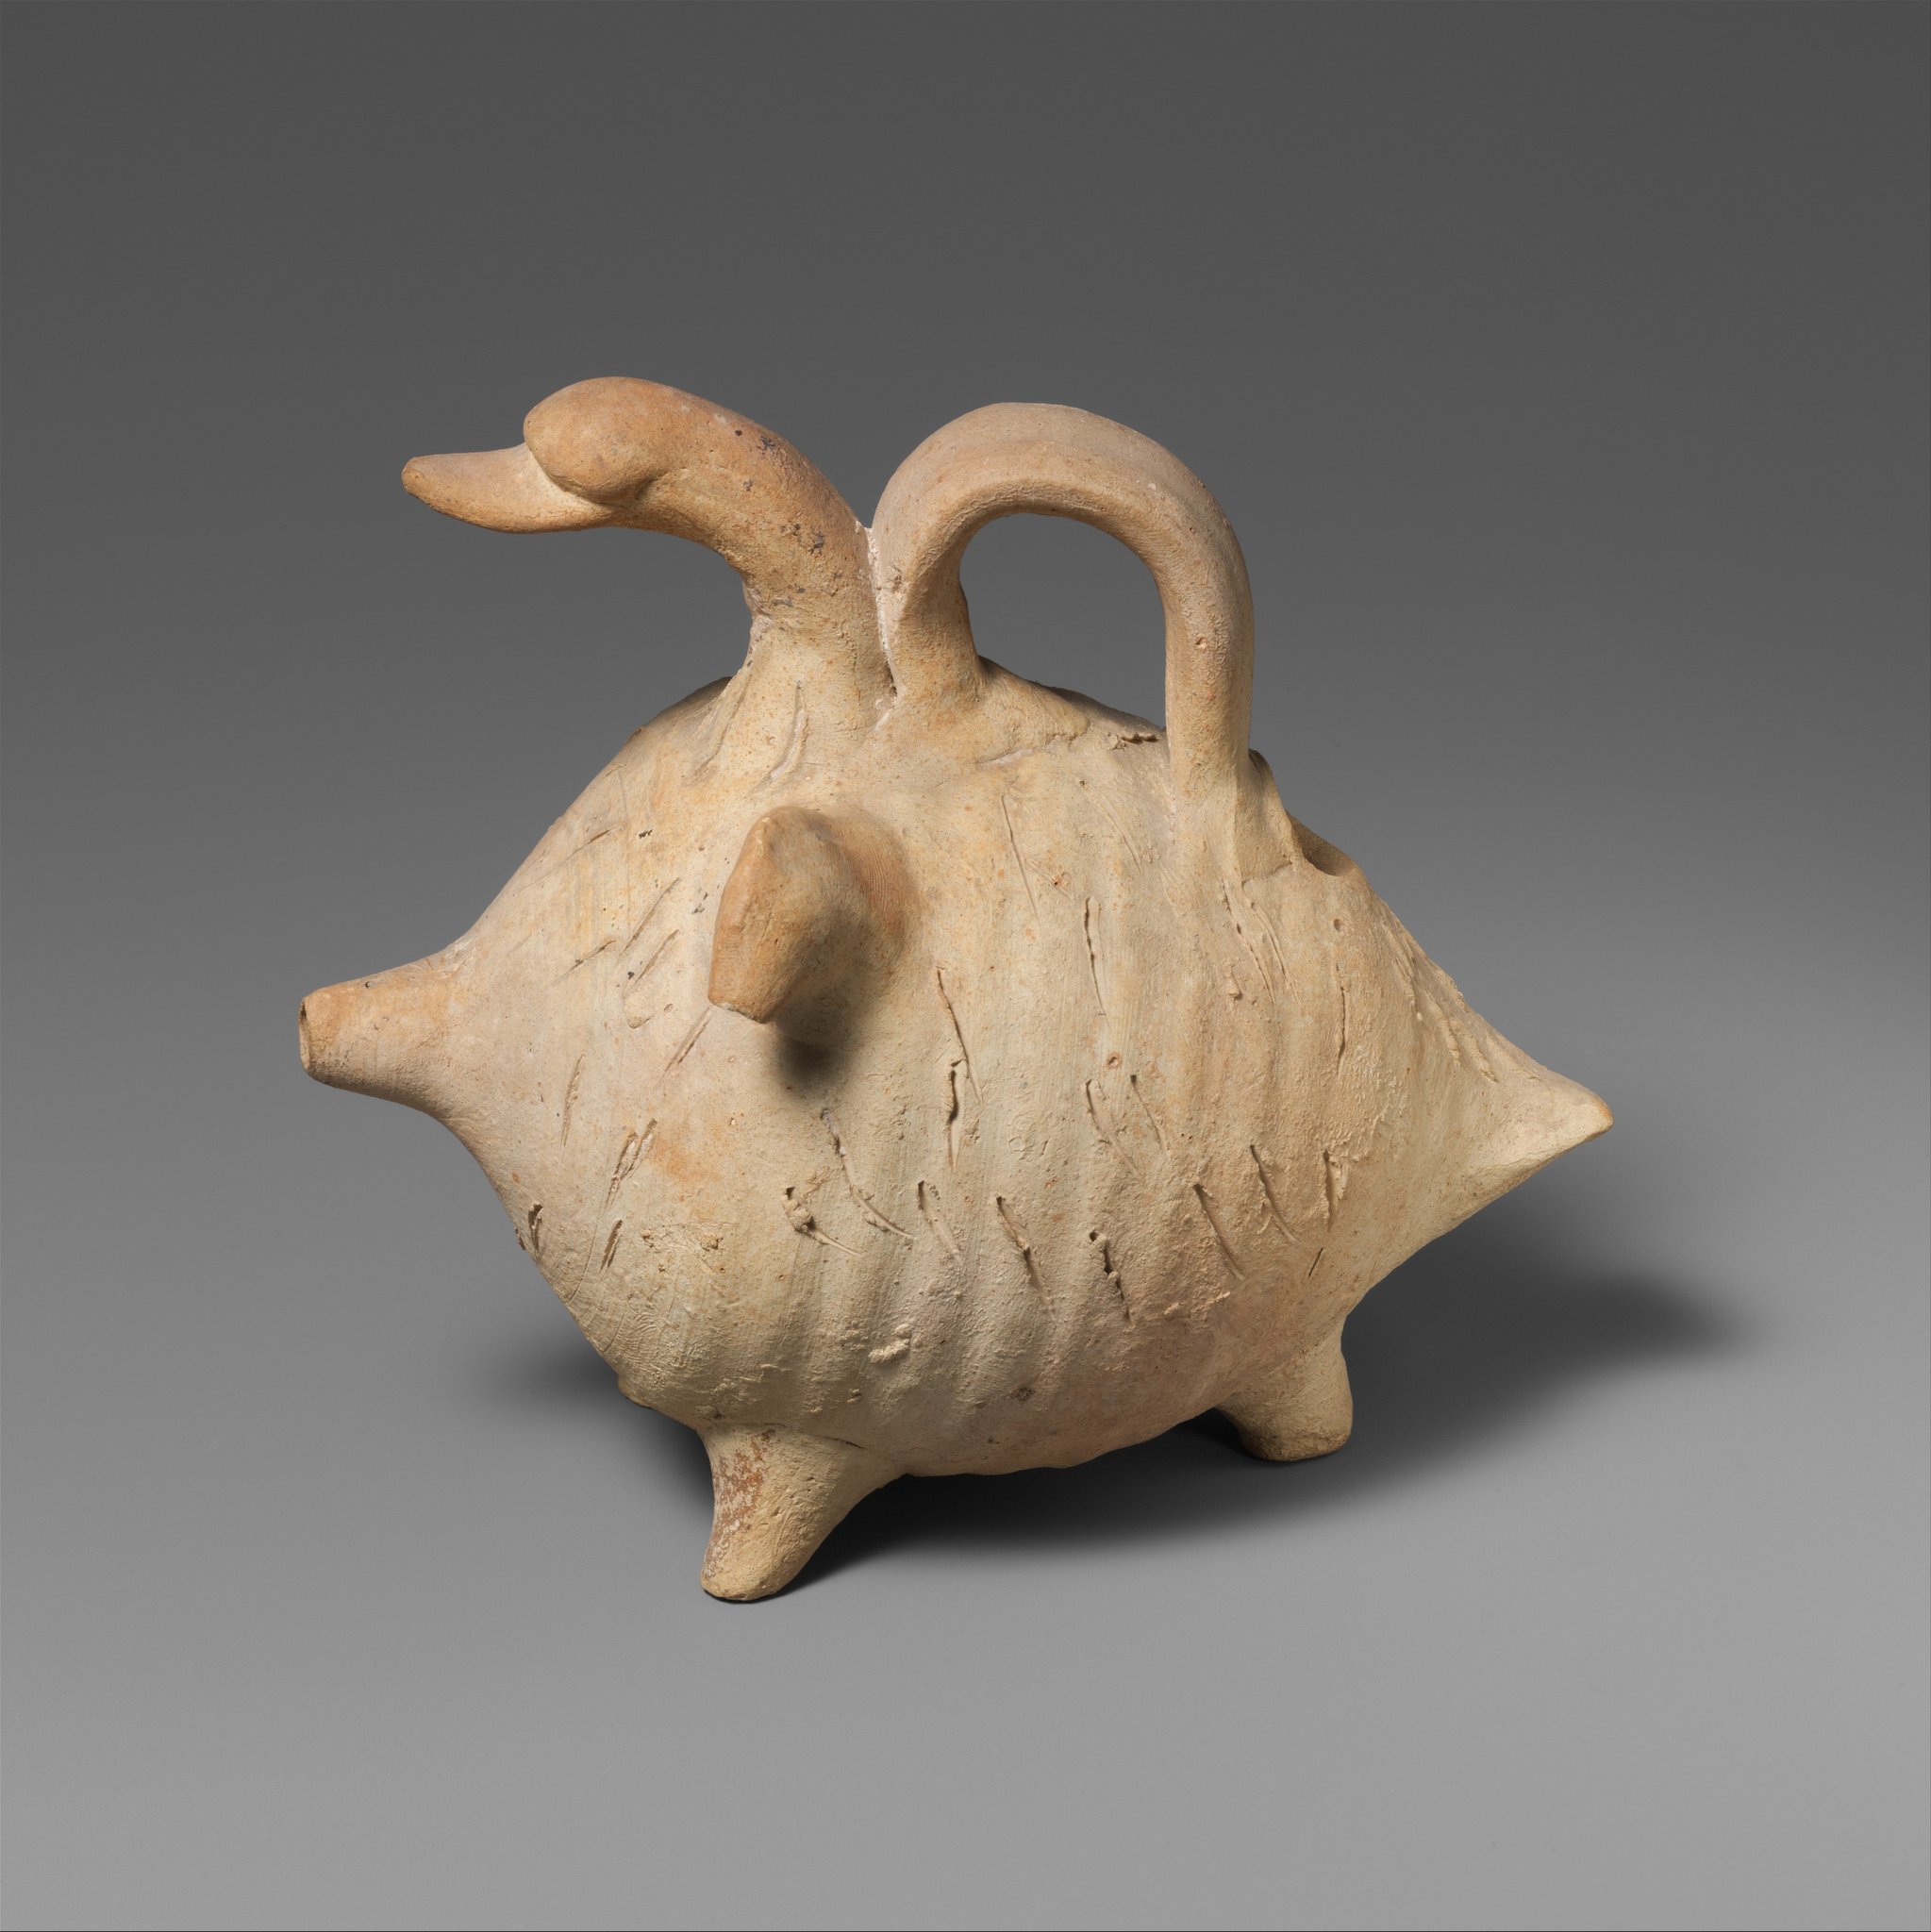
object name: askos in the form of a duck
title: Terracotta duck-shaped askos (flask with spout and handle over the back)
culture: cypriot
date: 850-750 BCE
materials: terracotta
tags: ducks